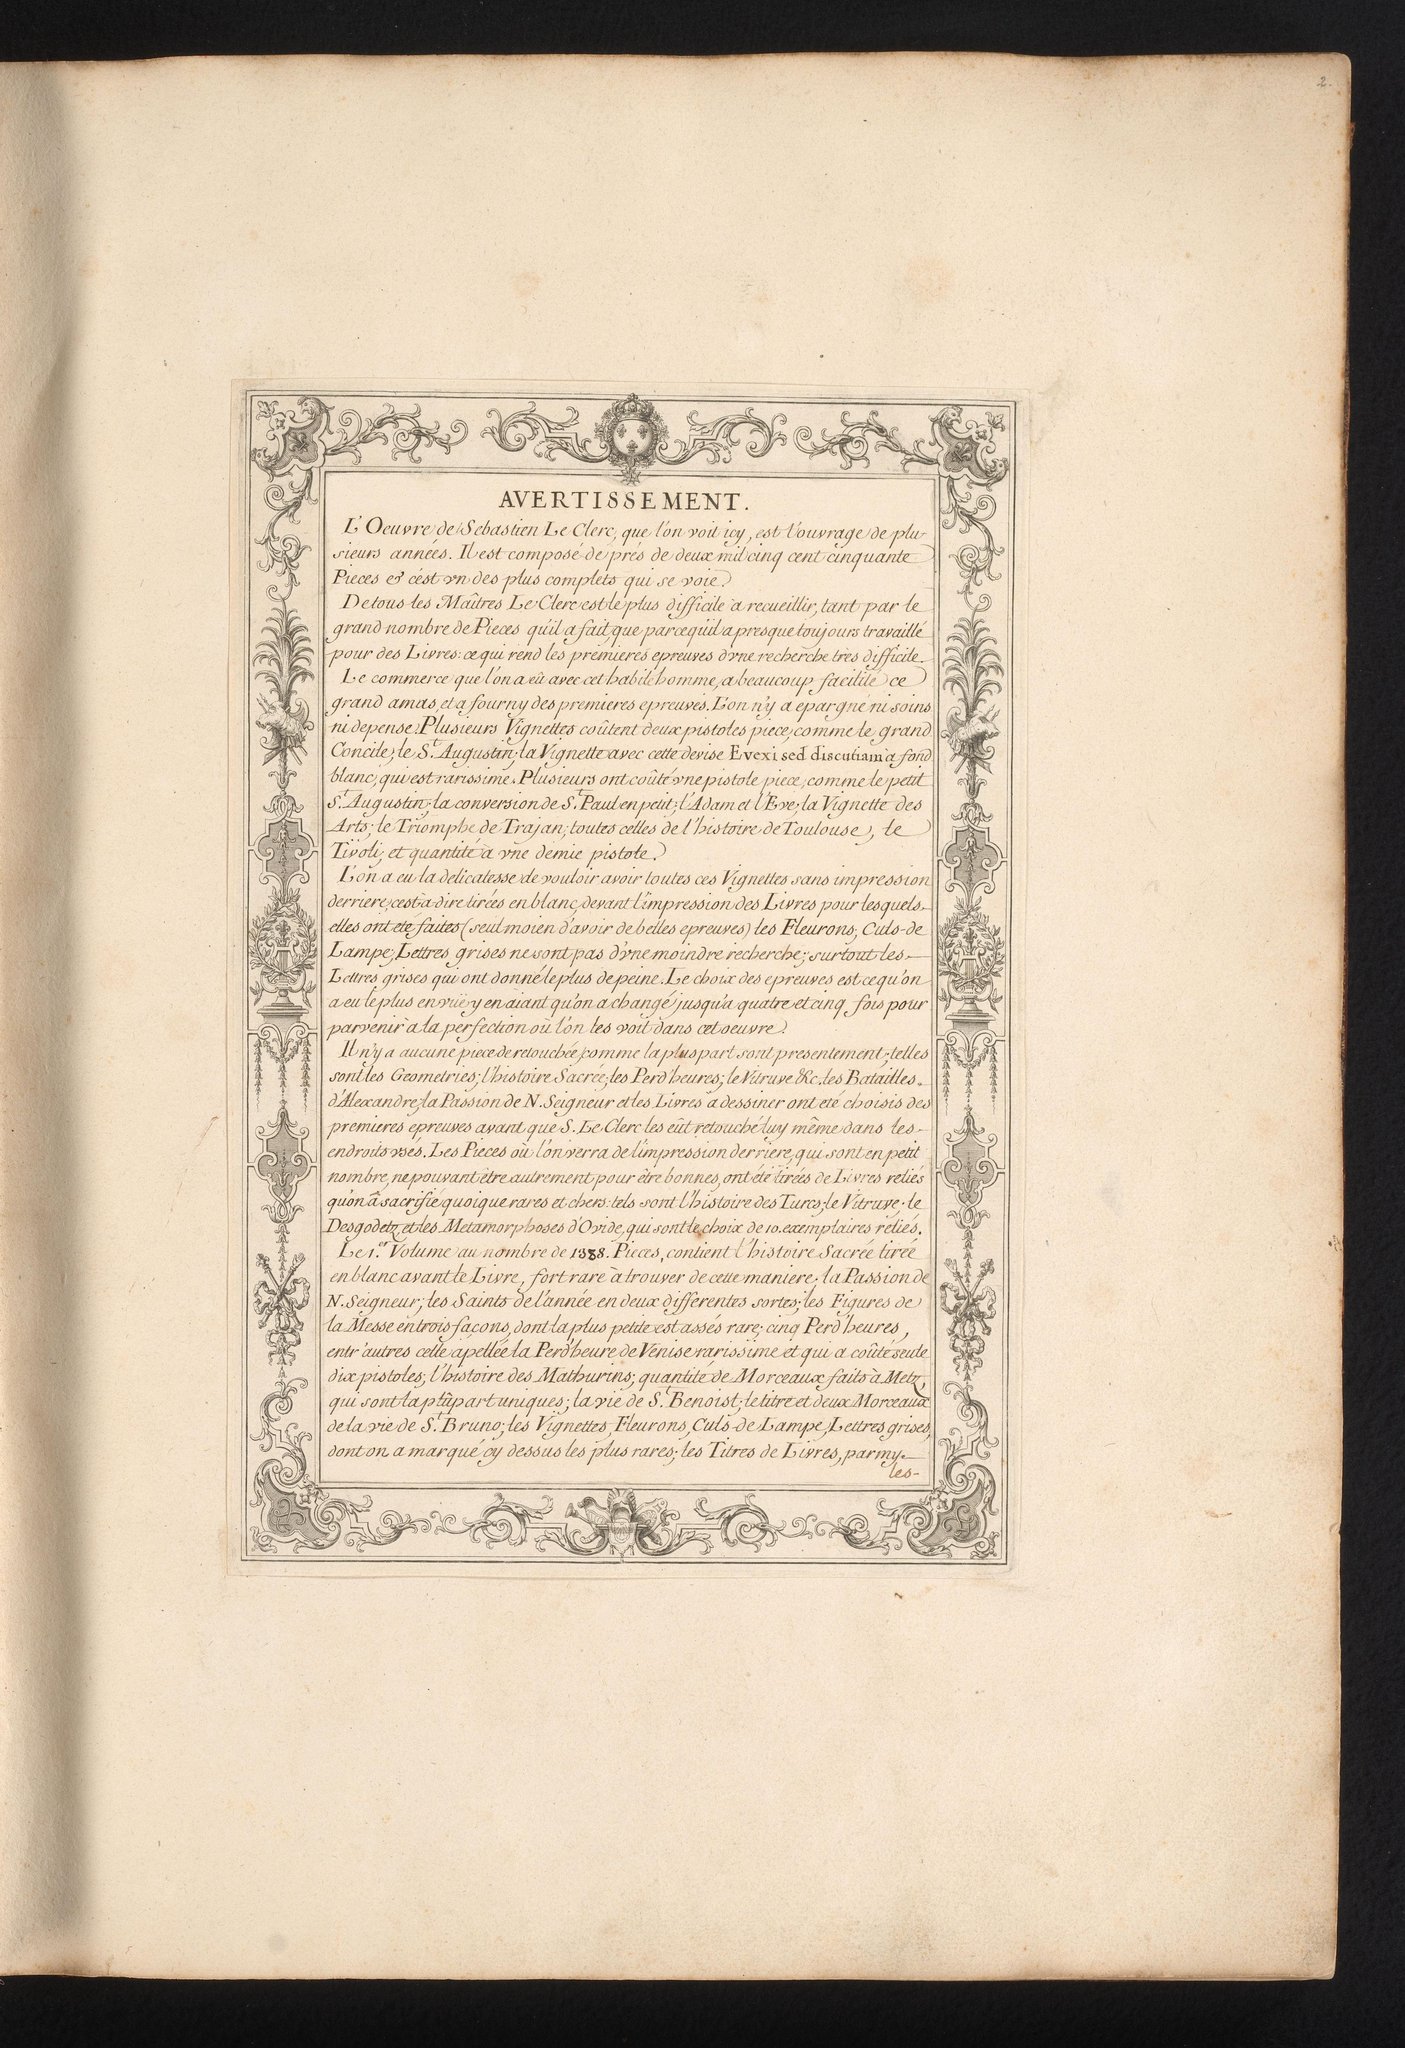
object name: album leaf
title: Avertissement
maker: Anonymous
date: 1647-1714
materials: ink, paper, pencil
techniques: etching, pen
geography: france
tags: ornament derived from objects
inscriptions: collector's mark: Lugt 2166, collector's mark: Lugt 2165